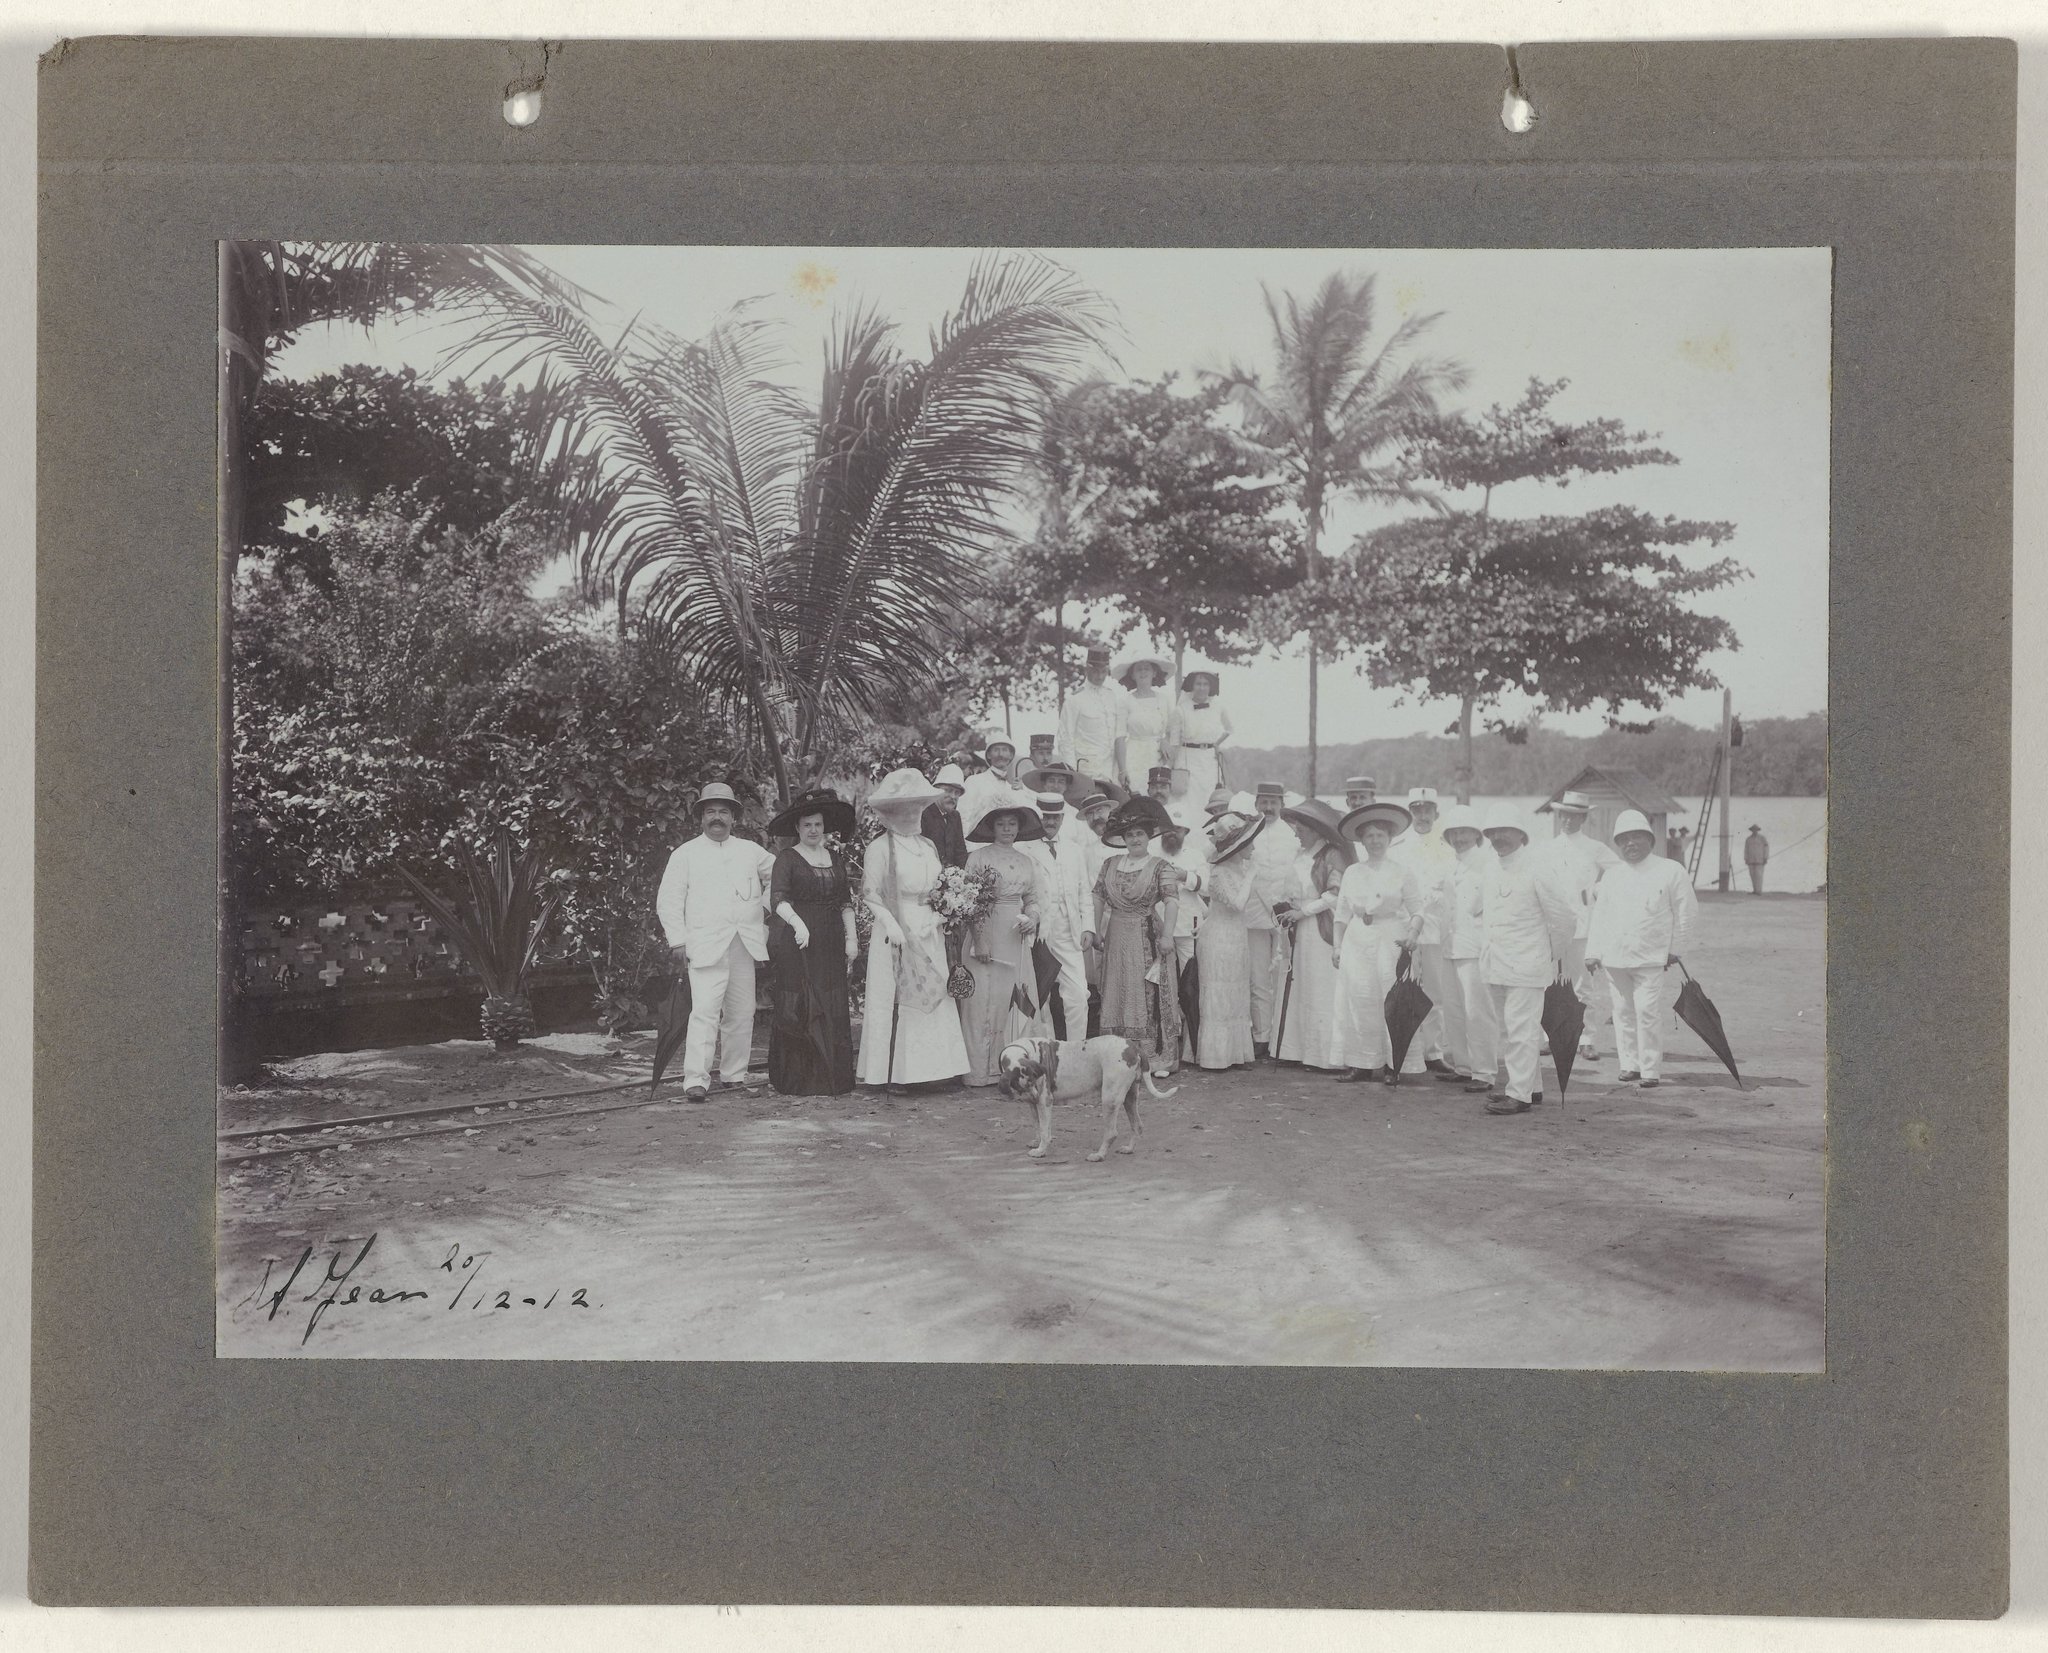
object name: photograph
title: Gezelschap poseert bij rivier in Saint Jean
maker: Anonymous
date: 1912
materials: cardboard, photographic support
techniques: photography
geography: french guiana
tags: anonymous historical persons portrayed in a group, in a group-portrait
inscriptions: date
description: Groepsportret van een gezelschap poserend bij de rivier in Saint-Jean-du-Maroni in Frans Guyana op 20 december 1912. Onderdeel van een groep foto's van de familie Boom-Gonggrijp in Suriname.